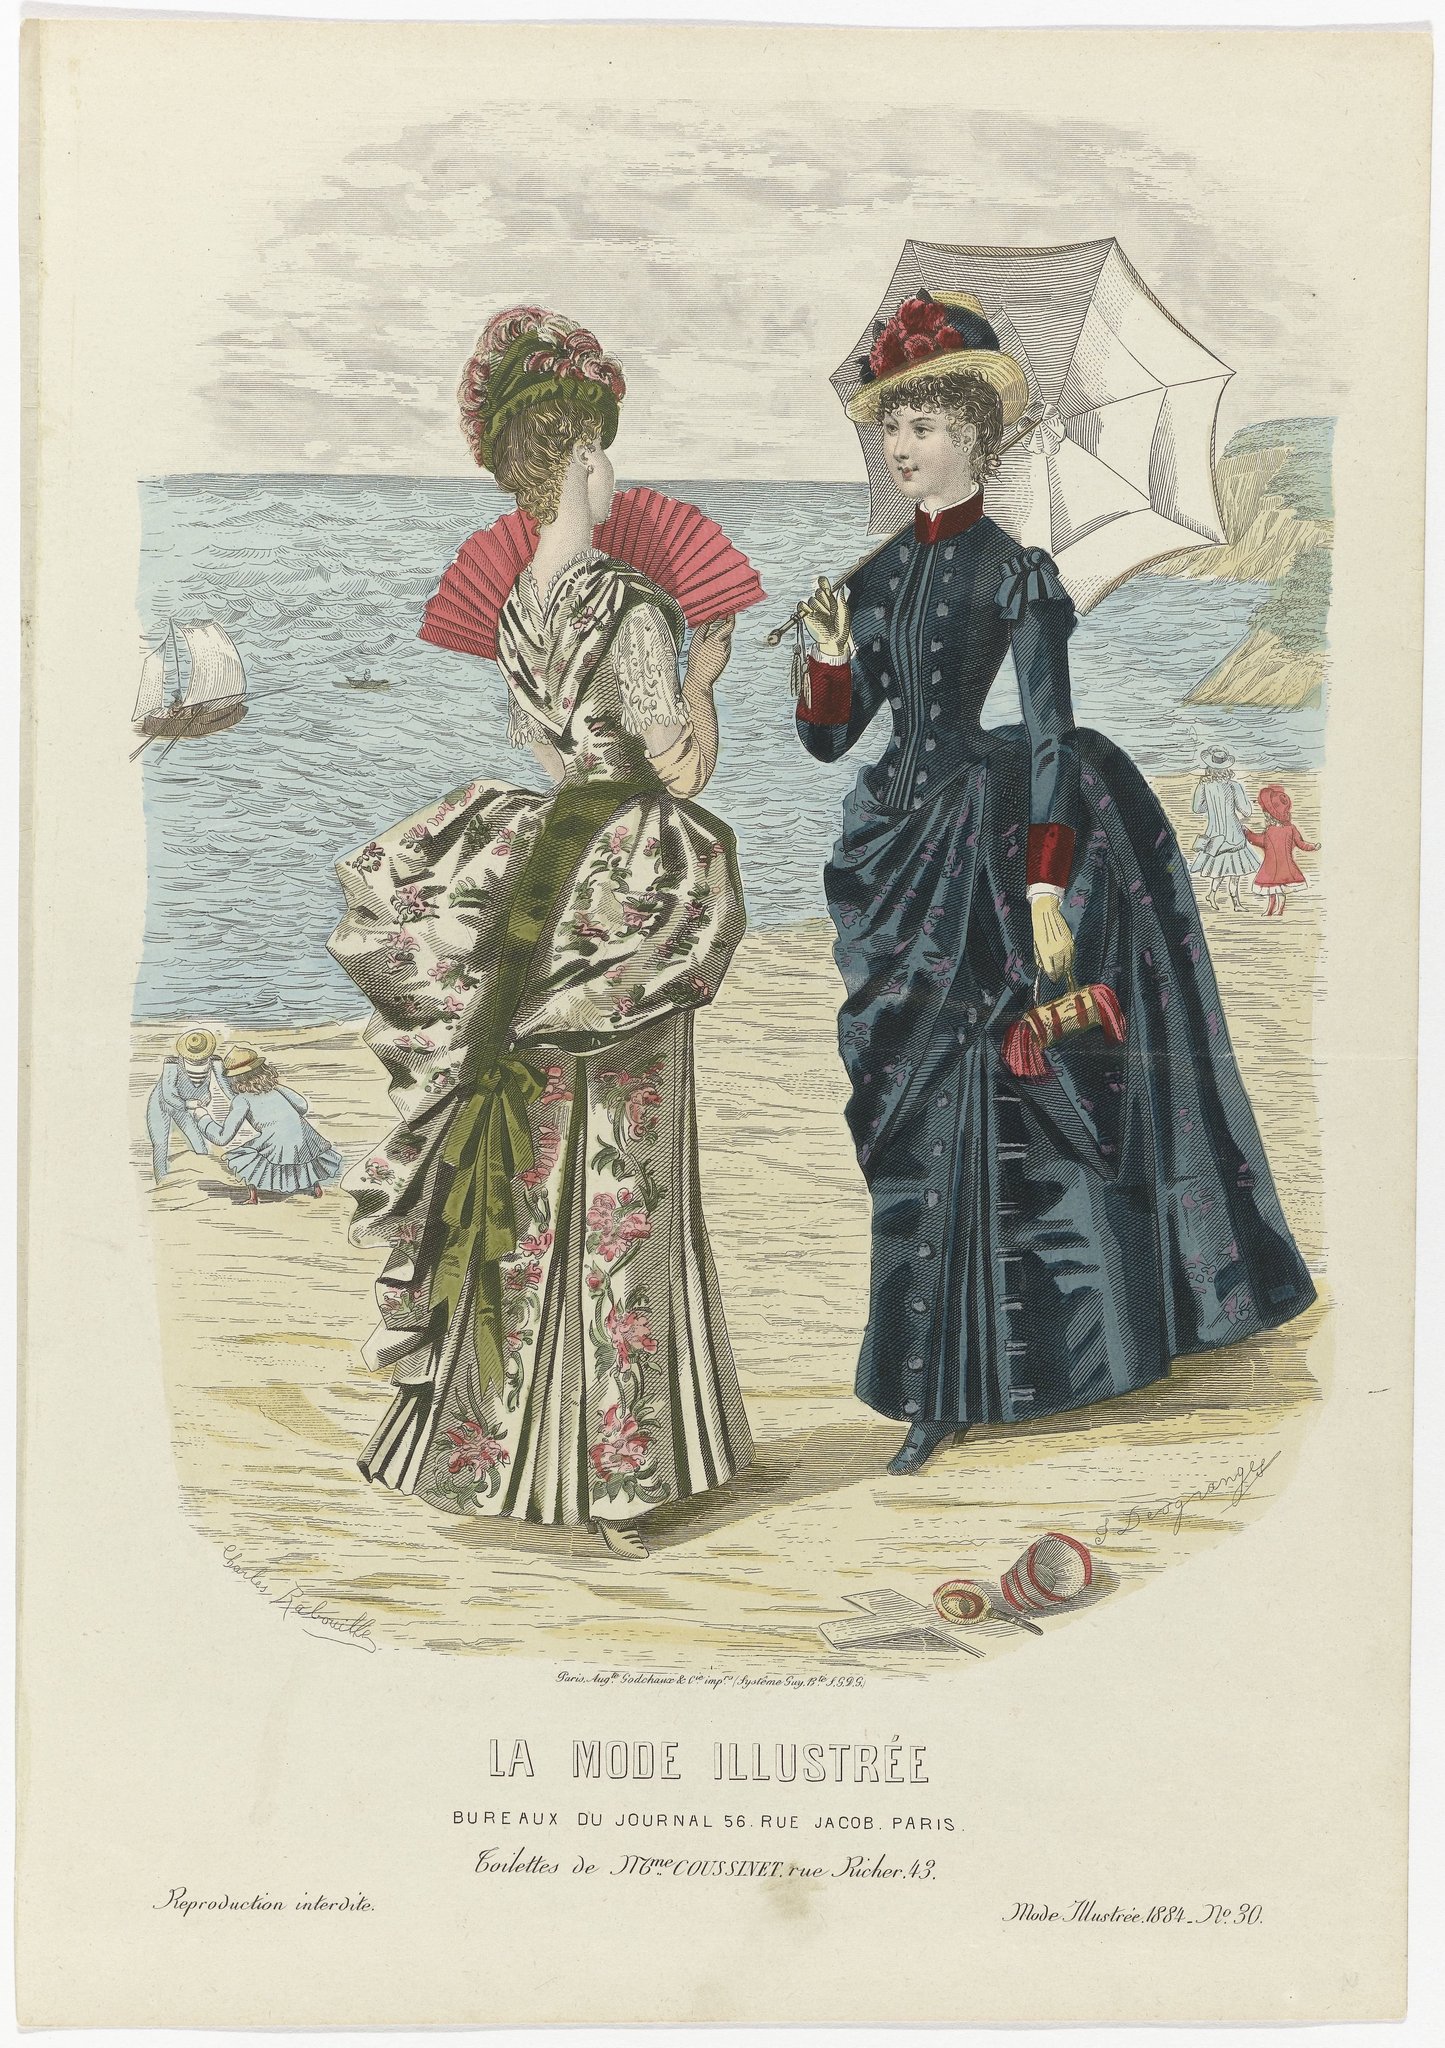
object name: fashion print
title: La Mode Illustrée, 1884, No. 30 : Toilettes de Mme Coussinet (...)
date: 1884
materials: paper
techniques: engraving, hand coloring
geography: paris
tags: bag (handbag) (+ women's clothes), (building) sand-castle, fashion plates, head-gear: hat (+ women's clothes), shoes, sandals (+ women's clothes), gloves, mittens, etc. (+ women's clothes), dress, gown (+ women's clothes), sea (seascape), fan (+ women's clothes), parasol, sunshade (+ women's clothes)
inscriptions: title: ‘La Mode Illustrée’, caption: ‘Toilettes de M.me Coussinet. rue Richer. 43.’, address: ‘Bureaux du journal, 56, rue Jacob. Paris’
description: Twee vrouwen, van wie één op de rug gezien, op het strand. Op de achtergrond de zee en enkele spelende kinderen. Volgens het onderschrift: ensembles van Coussinet. Prent uit het modetijdschrift La Mode Illustrée (1860-1937).